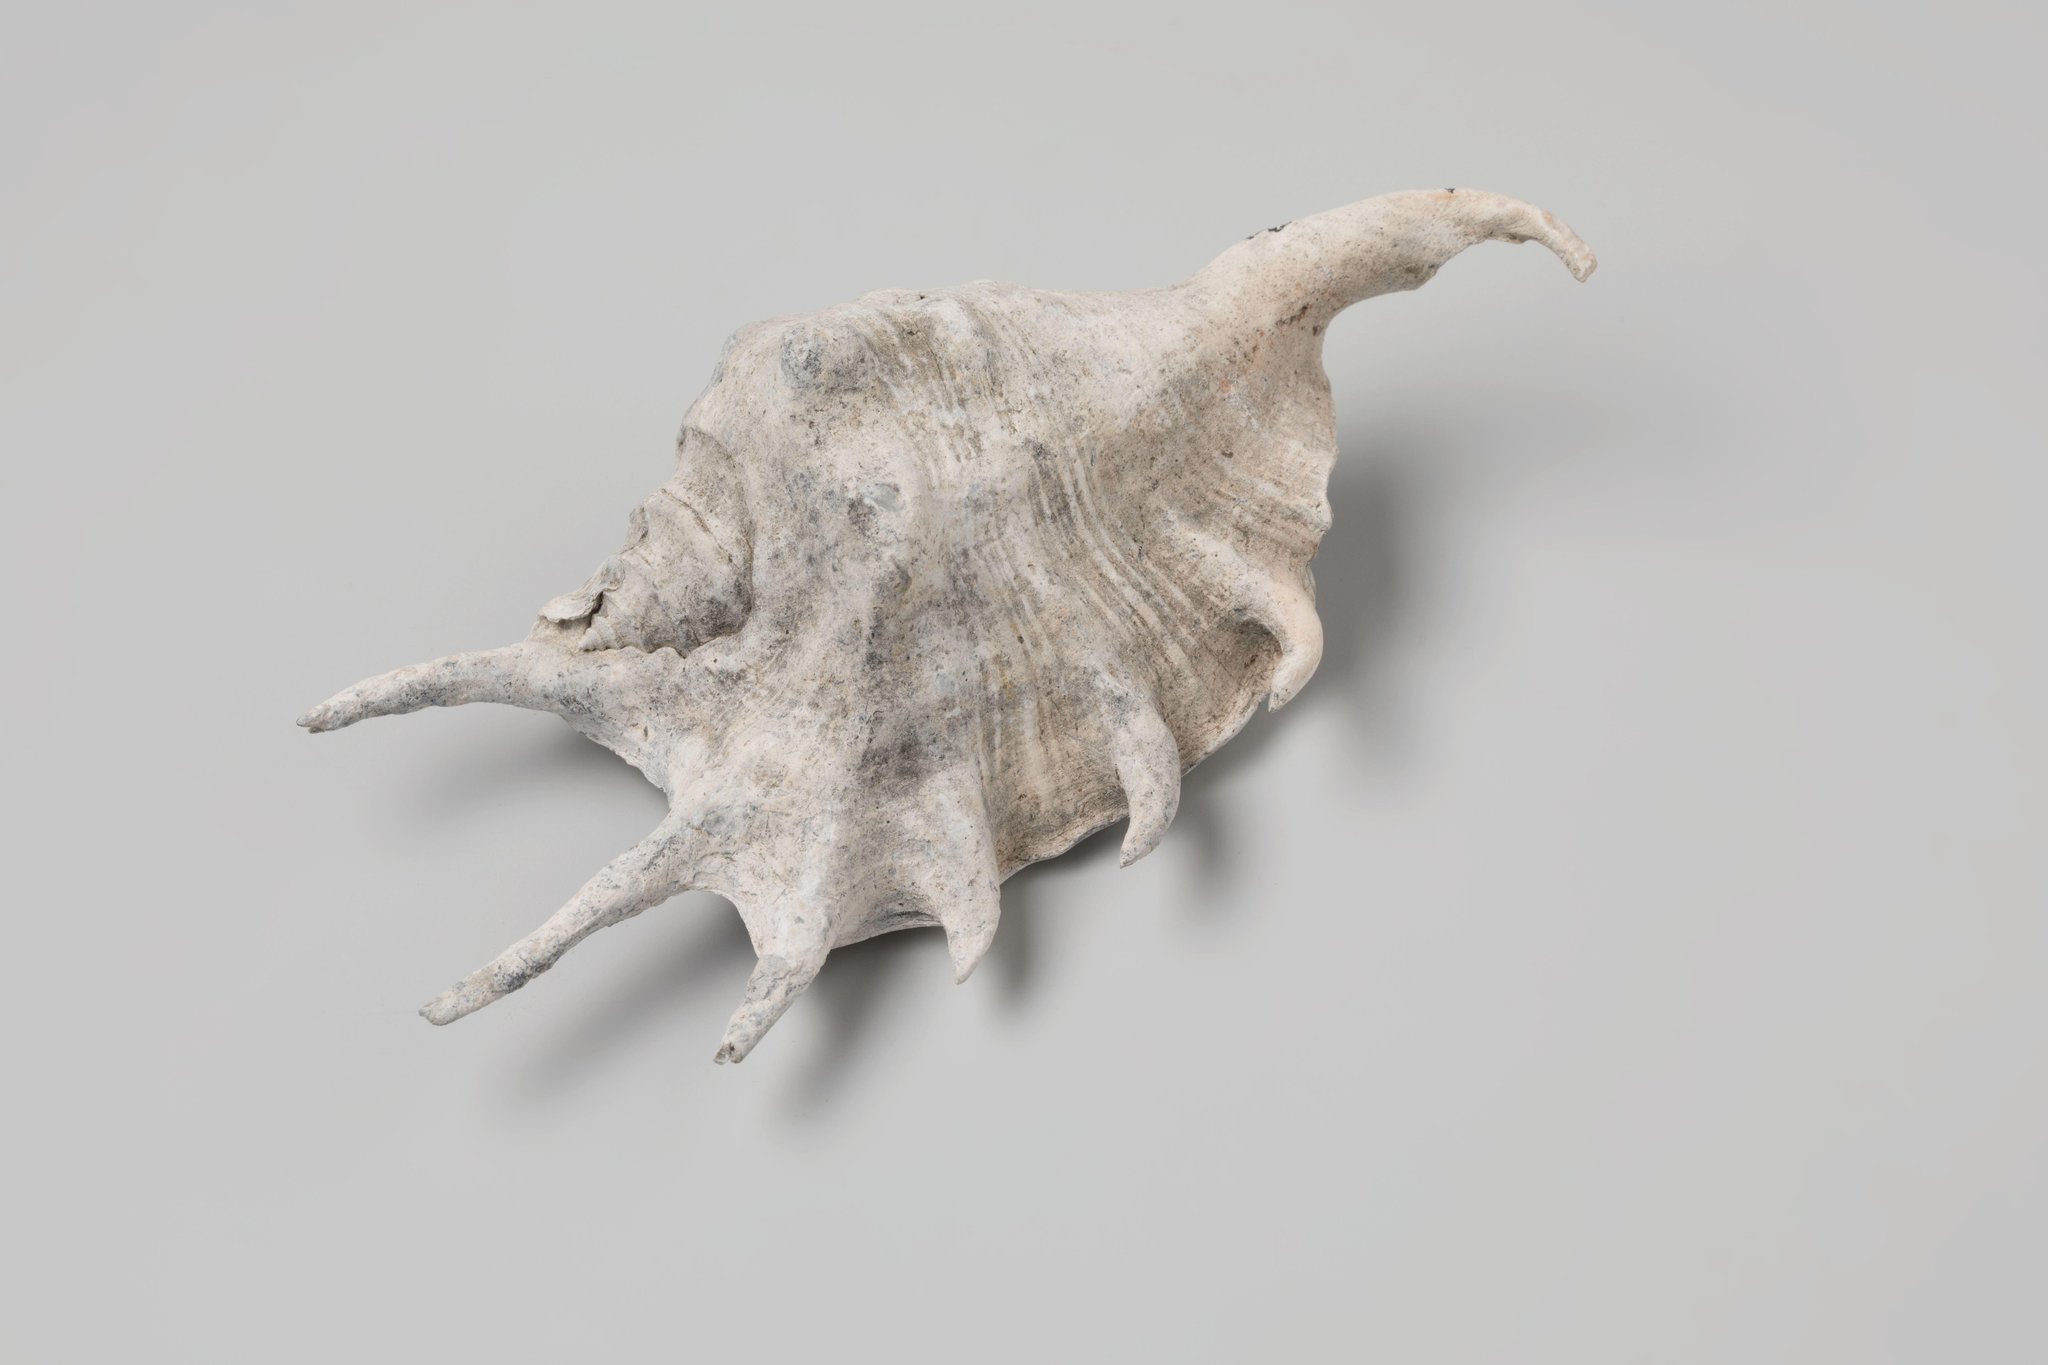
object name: lambis lambis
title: Lambis lambis shell from the wreck of the Dutch East India ship Witte Leeuw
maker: niet van toepassing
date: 1613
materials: shell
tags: verenigde oostindische compagnie, sint-helena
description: Schelp uit V.O.C.-schip de 'Witte Leeuw'. Eén van vijf schelpen.